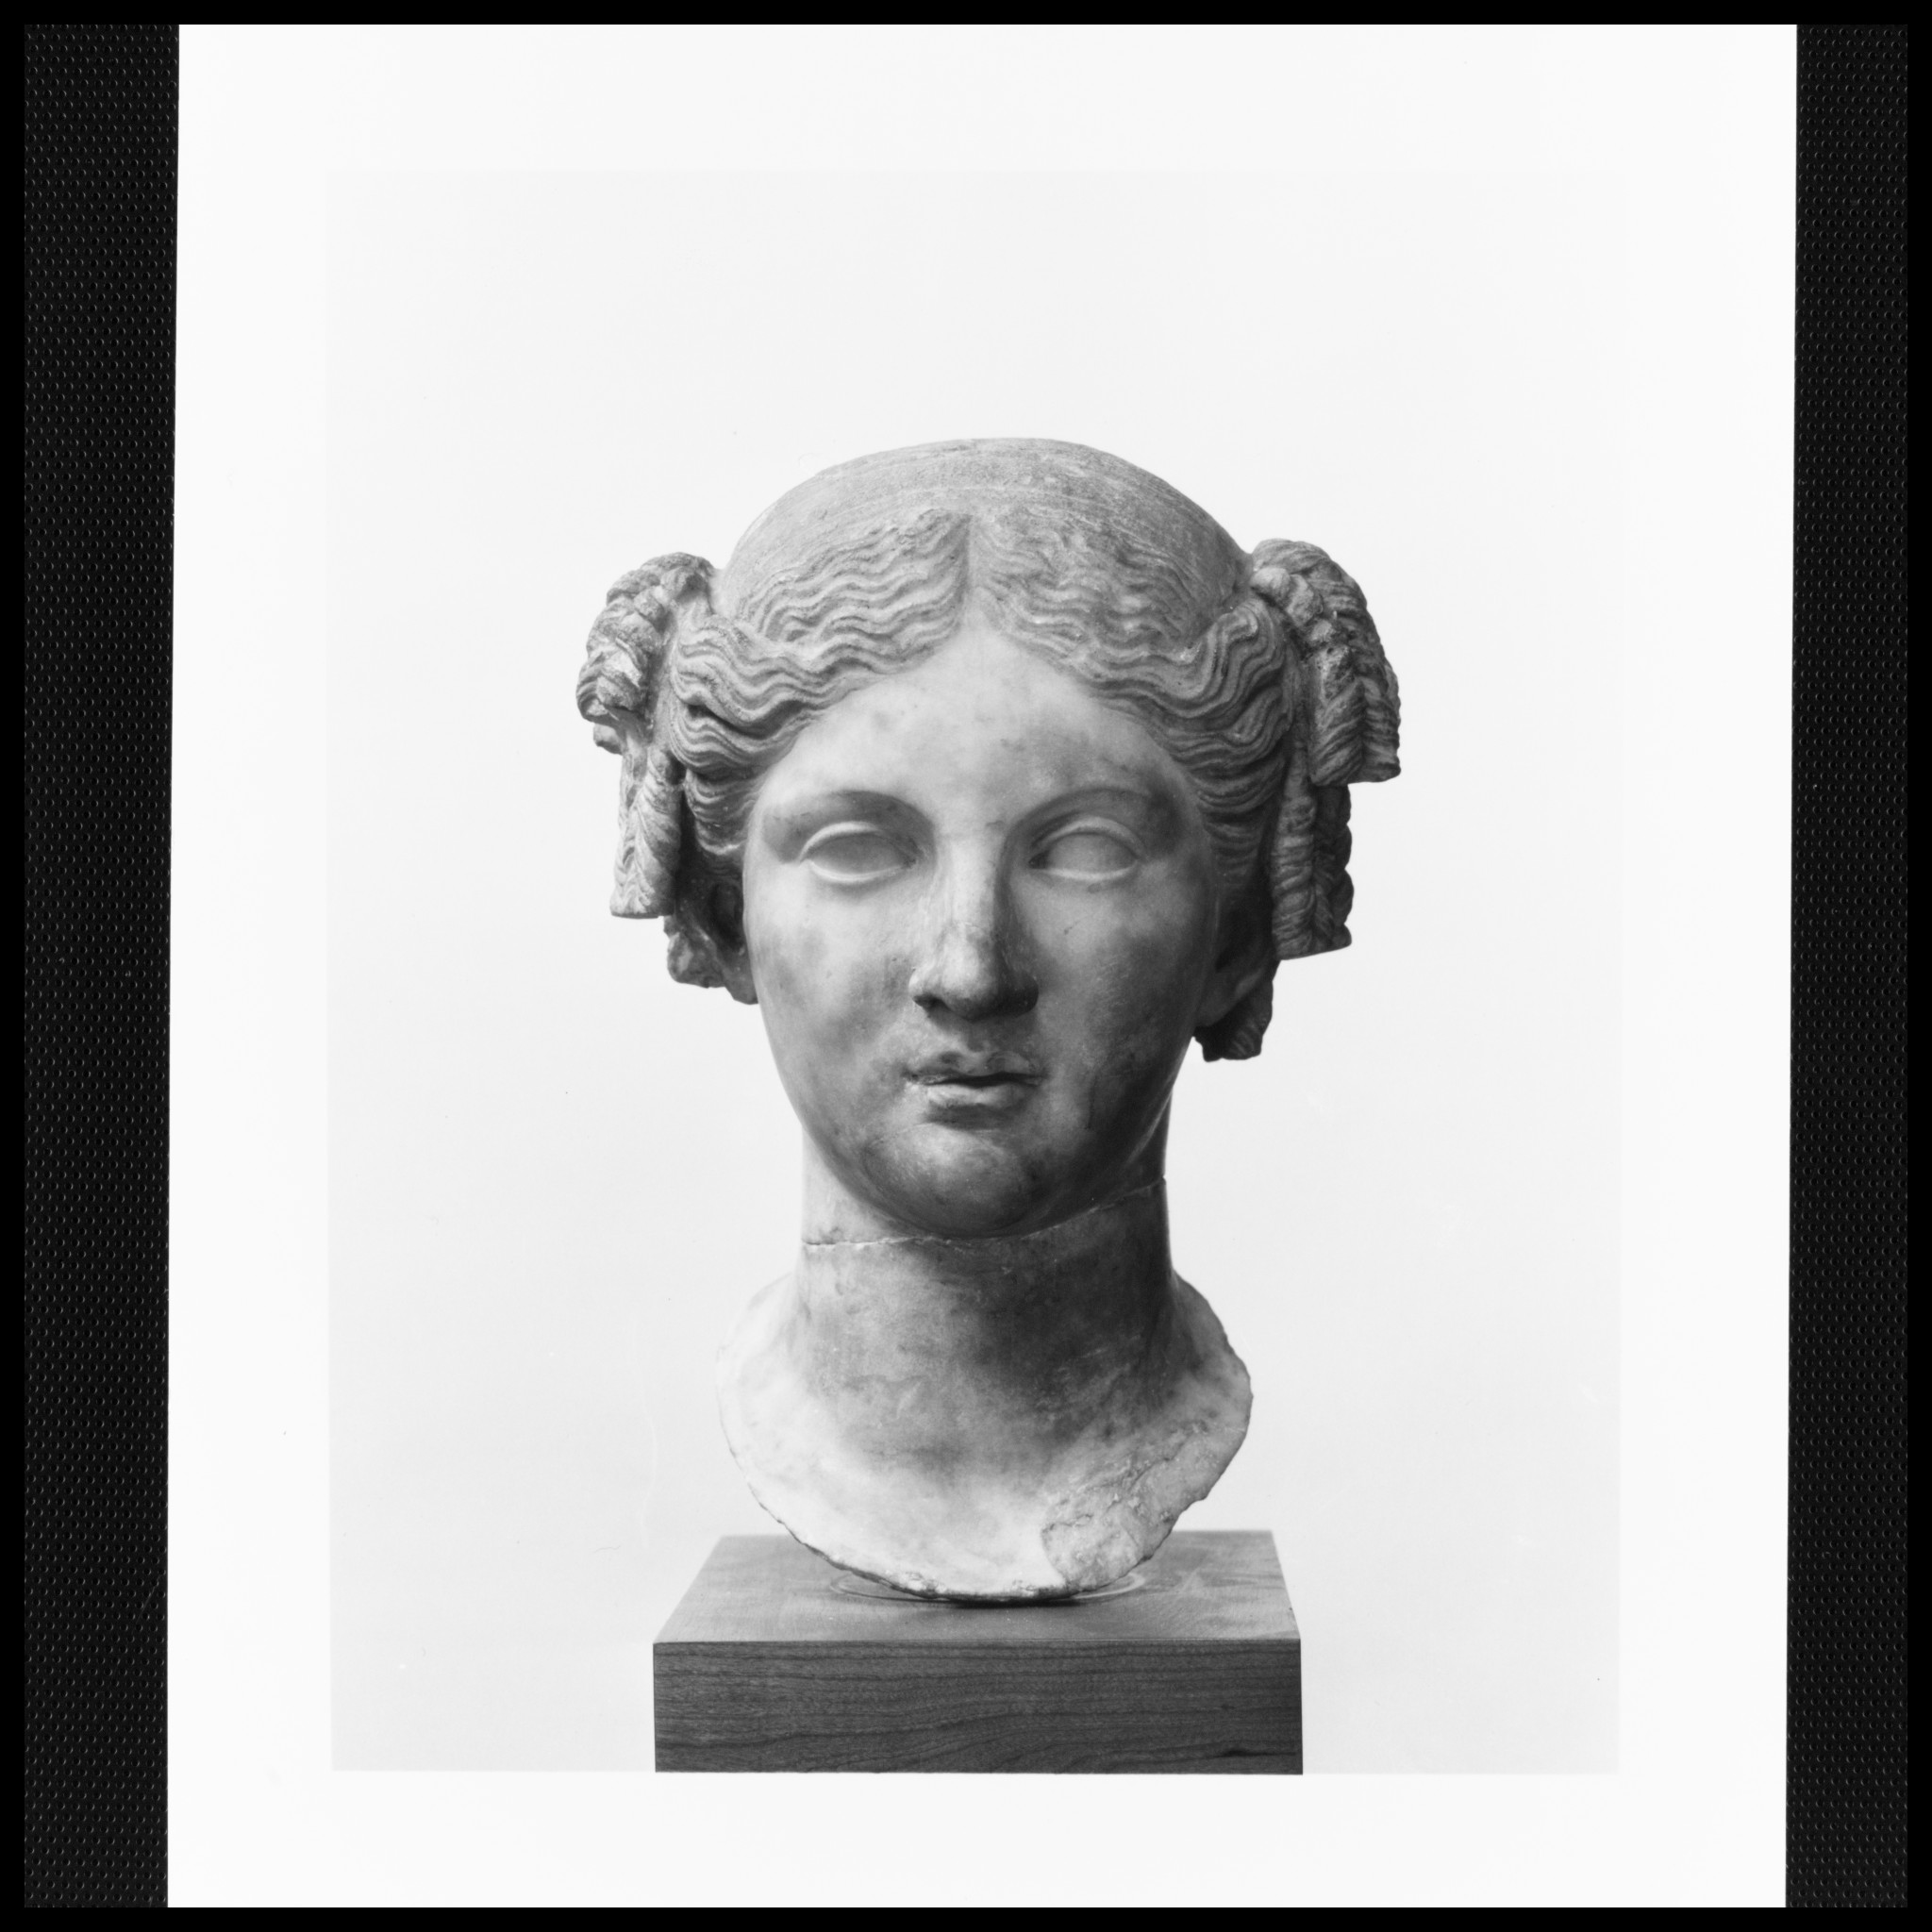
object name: portrait head of a woman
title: Marble head of a woman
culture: roman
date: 1-100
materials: marble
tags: heads,women